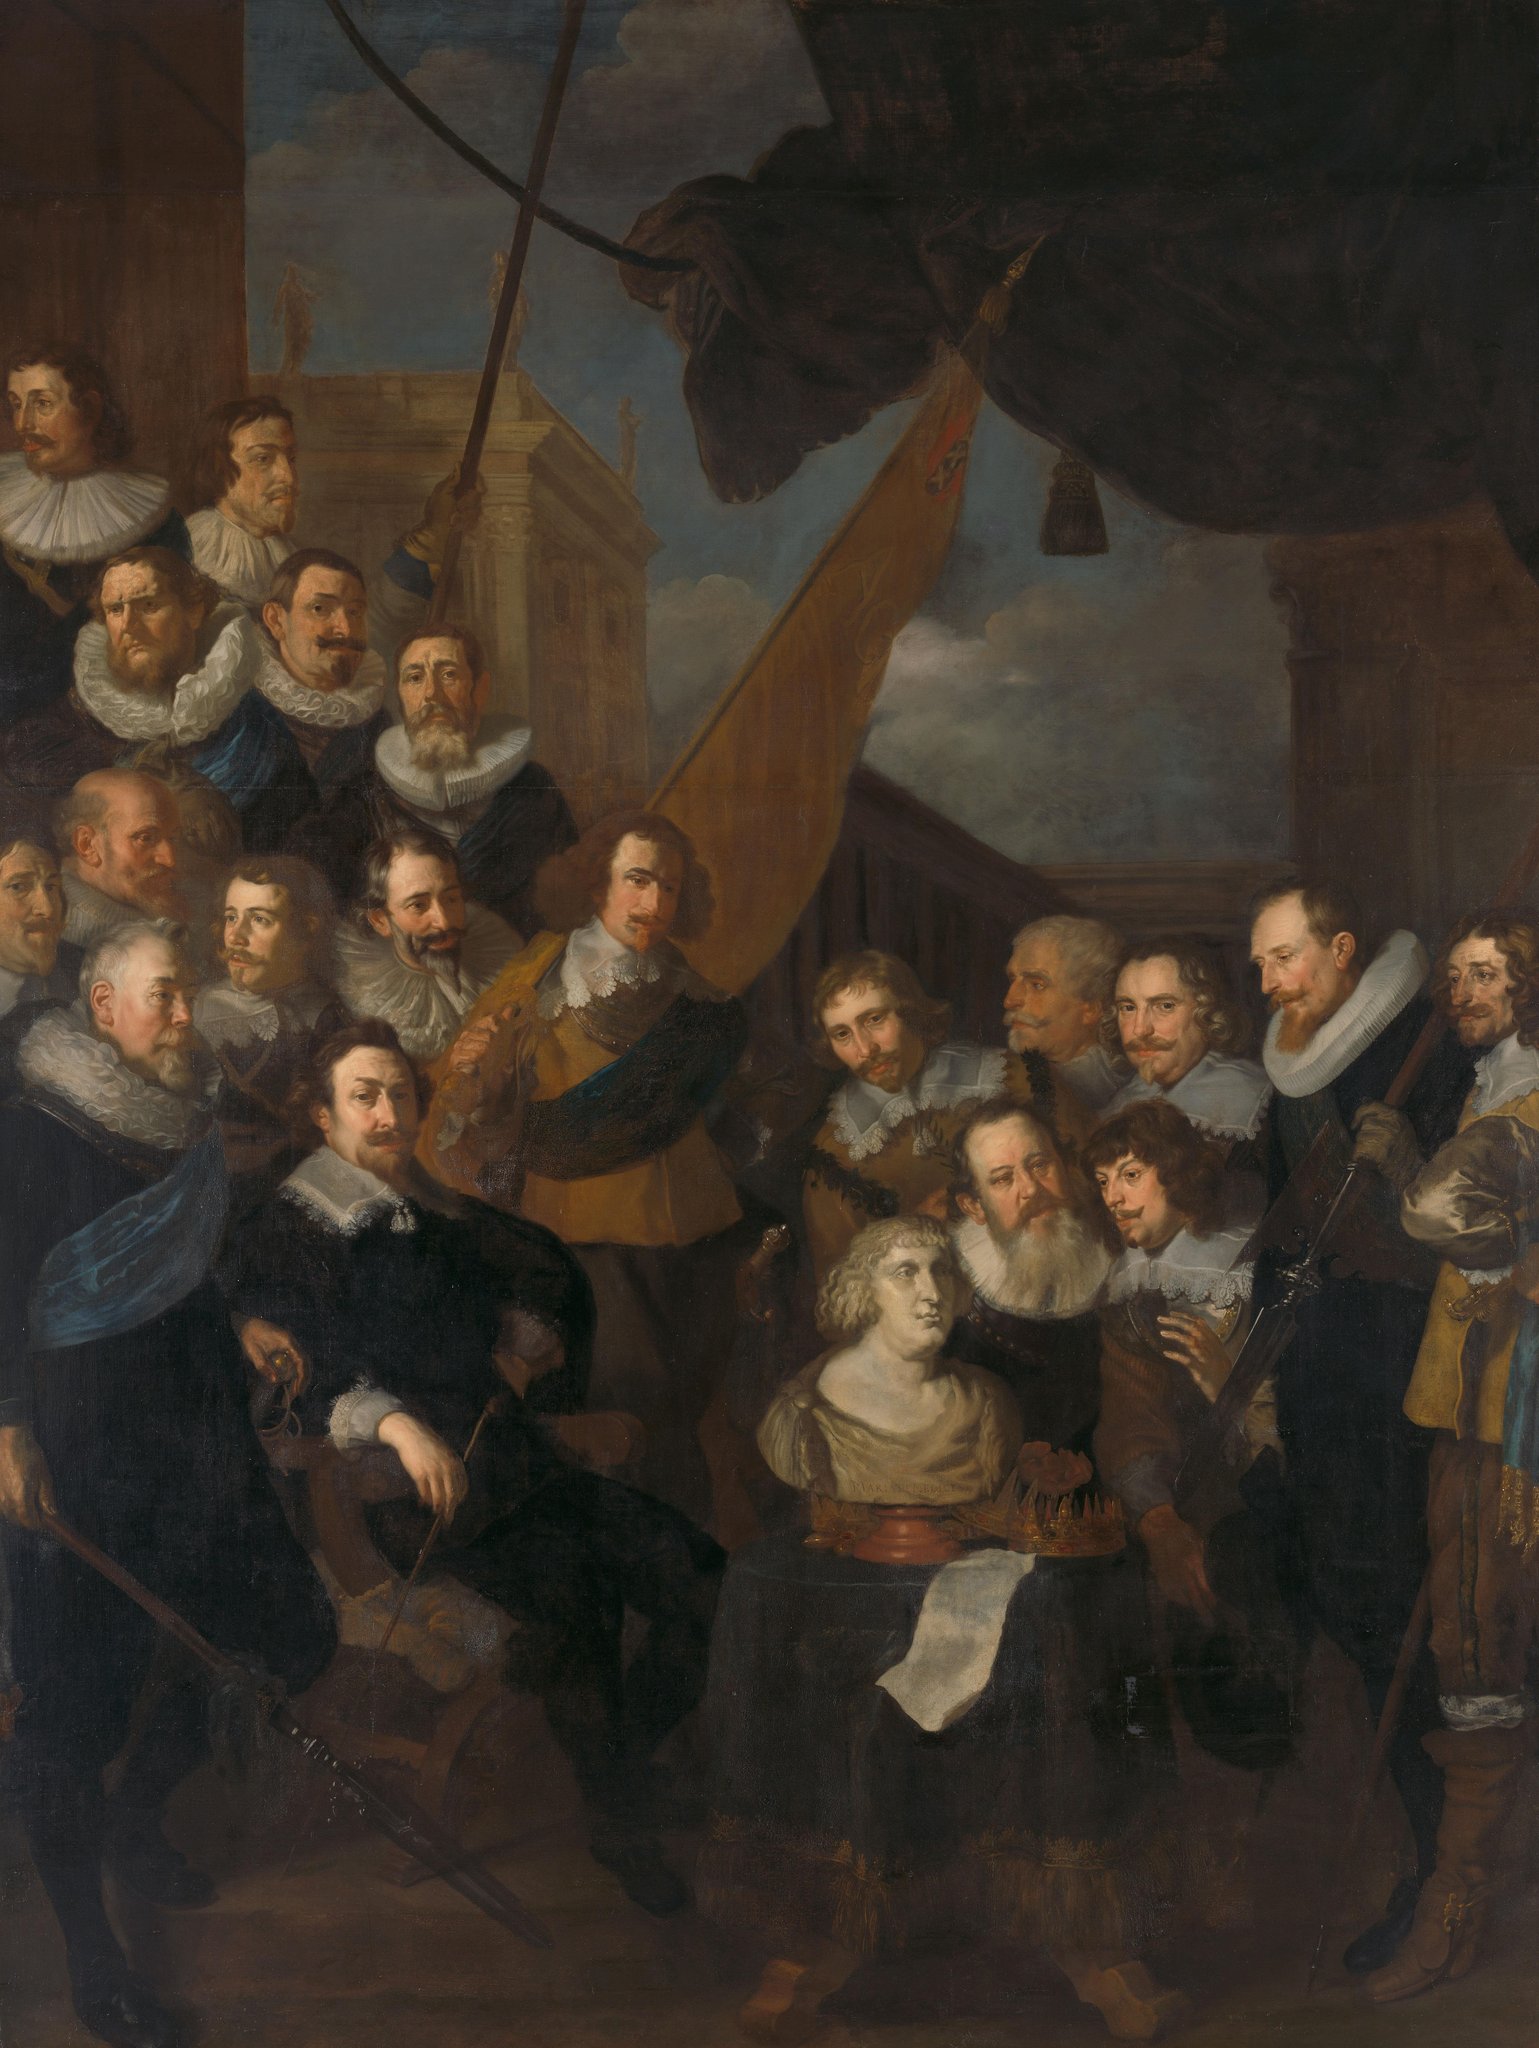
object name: painting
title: The company of Captain Cornelis Bicker and Lieutenant Frederick van Banchem, waiting to welcome Maria de' Medici, dowager queen of France, on her visit to Amsterdam, September 1638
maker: joachim von sandrart (i)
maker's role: draughtsman, painter, print maker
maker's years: 1606-1688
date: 1640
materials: canvas, oil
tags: amsterdam, maria de' medici, warfare; military affairs (+ citizen soldiery, civil guard, citizen militia), piece of sculpture, reproduction of a piece of sculpture, guard of honour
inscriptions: inscription: ‘Het Corporaalschap des Heeren van Swieten. Geschildert door Sandrart / De Vaan van Swieten wacht om Medicis te onthalen / maar voor zo groot een ziel is dan een markt te kleen / En 't oog der Burgerij te zwak voor zulke Straalen / Die zon van 't Christenrijk, is vleesch, nog vel, nog been / Vergeef het dan Sandrart, dat hij haar maakt van Steen. Vondel.’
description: Joachim von Sandrart (1606 - 1688). The company of Captain Cornelis Bicker, waiting to welcome Maria de' Medici, the dowager queen of France, 1638. The men of Cornelis Bicker served as a guard of honour when Maria de' Medici visited Amsterdam in 1638. They made this proud achievement the theme of their group portrait. The riflemen are grouped around a marble bust of Maria de' Medici. The sheet of paper beneath the bust contains a poem devoted to this painting by the famous 17th-century Dutch poet Vondel. Painted for the Great Hall of the Kloveniersdoelen, Amsterdam. On loan from the city of Amsterdam, 1885.